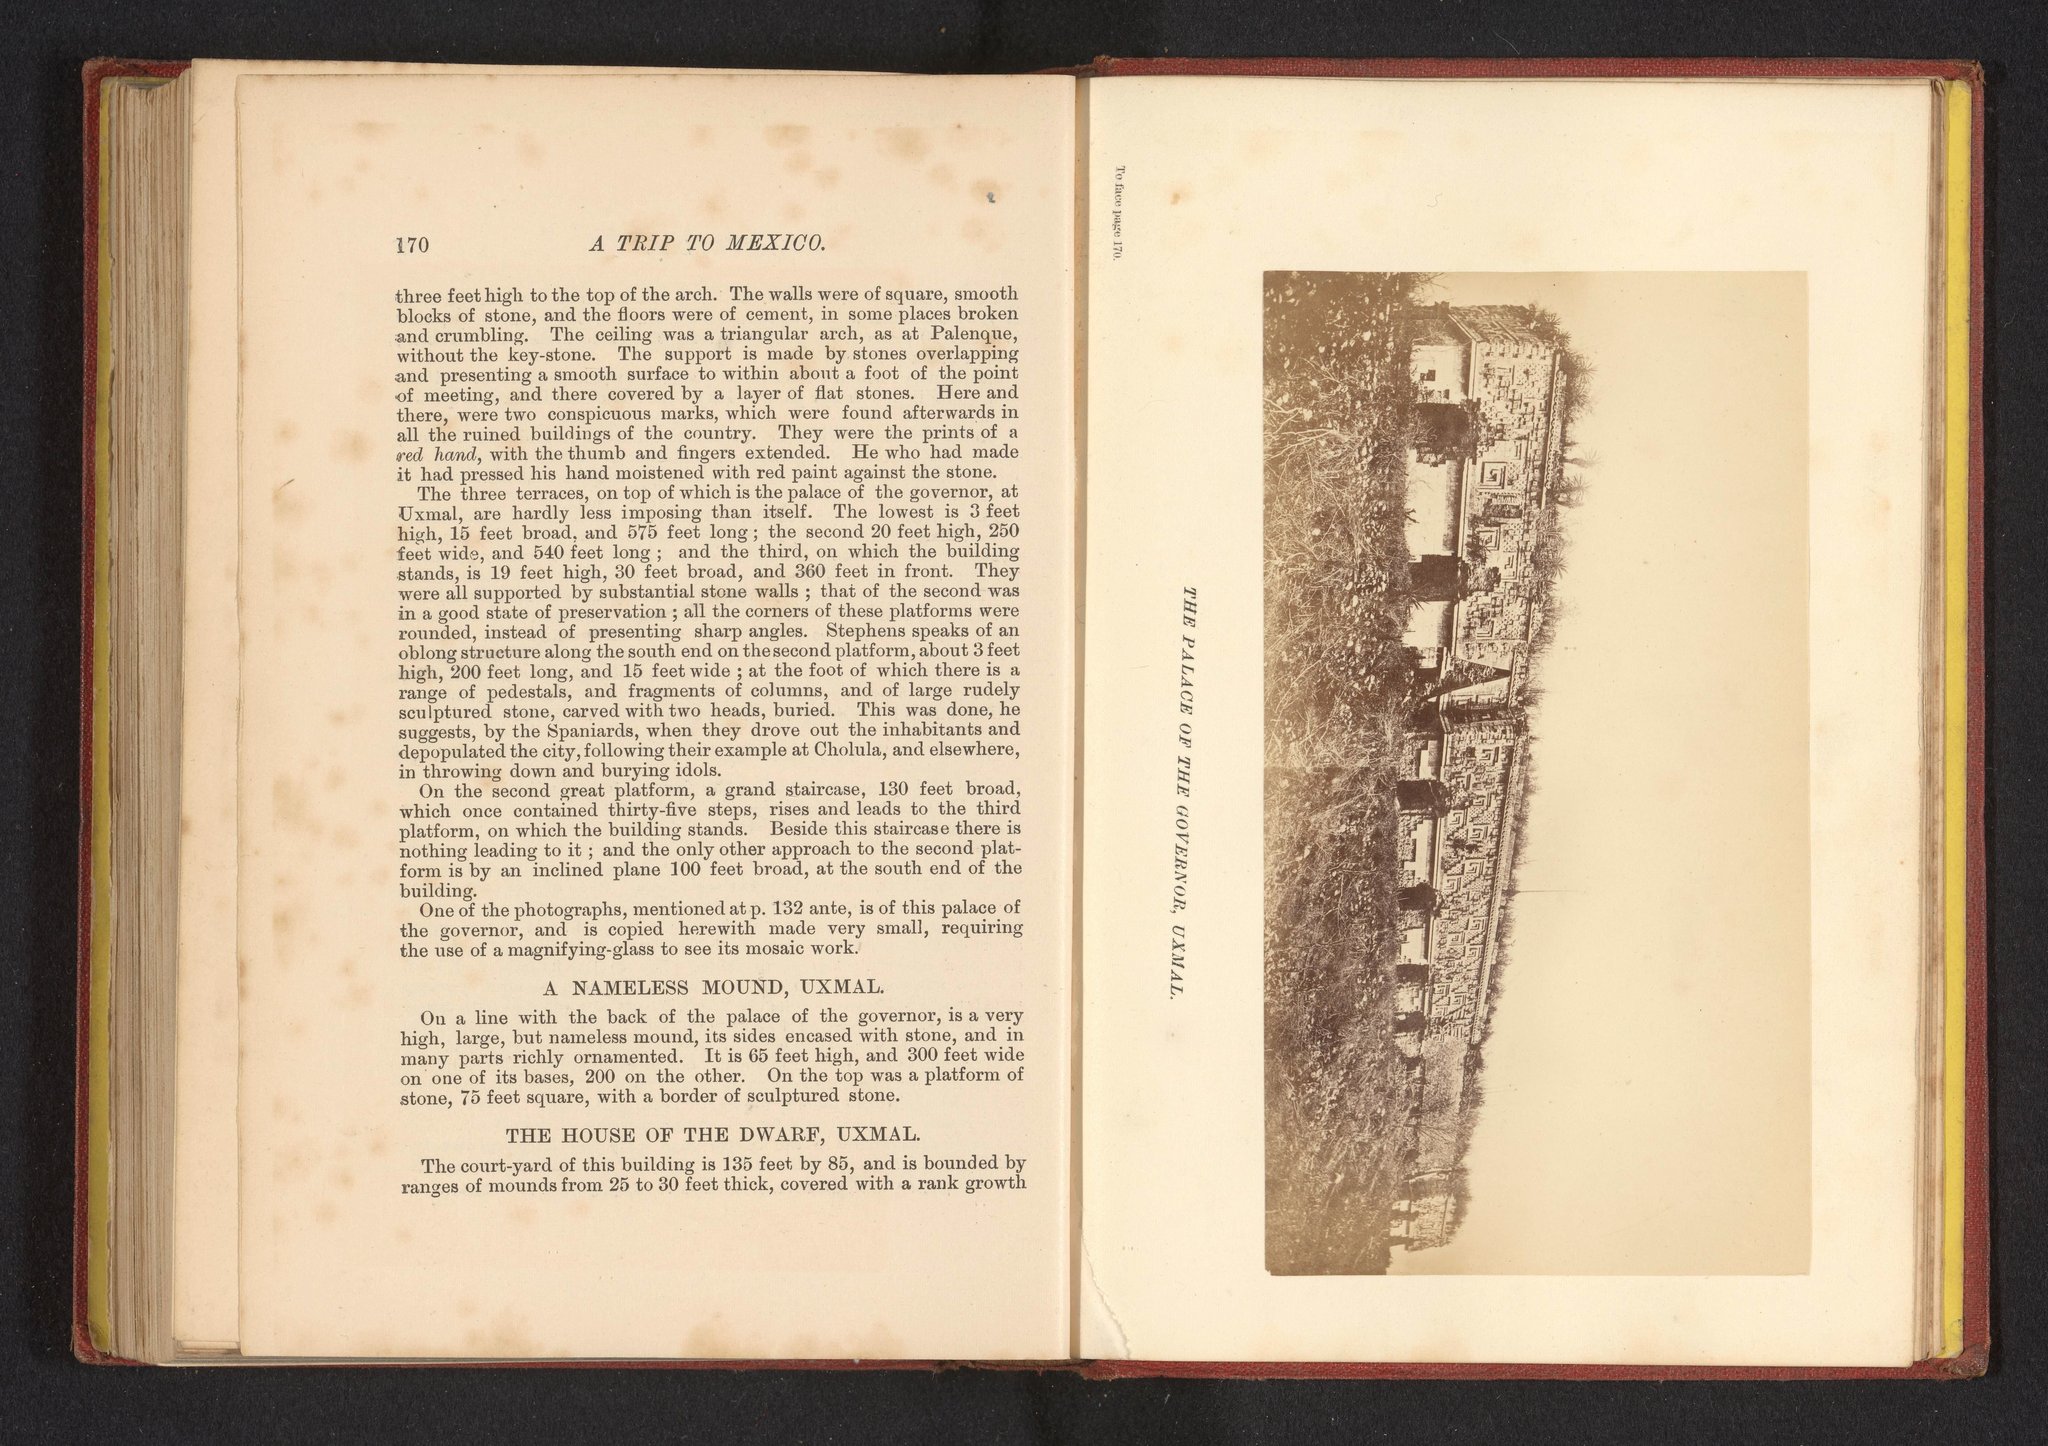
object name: page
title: The palace of the governor, Uxmal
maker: Anonymous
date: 1870-1880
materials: photographic support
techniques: albumen print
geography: uxmal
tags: palace, ruin of a dwelling, house, castle, etc.